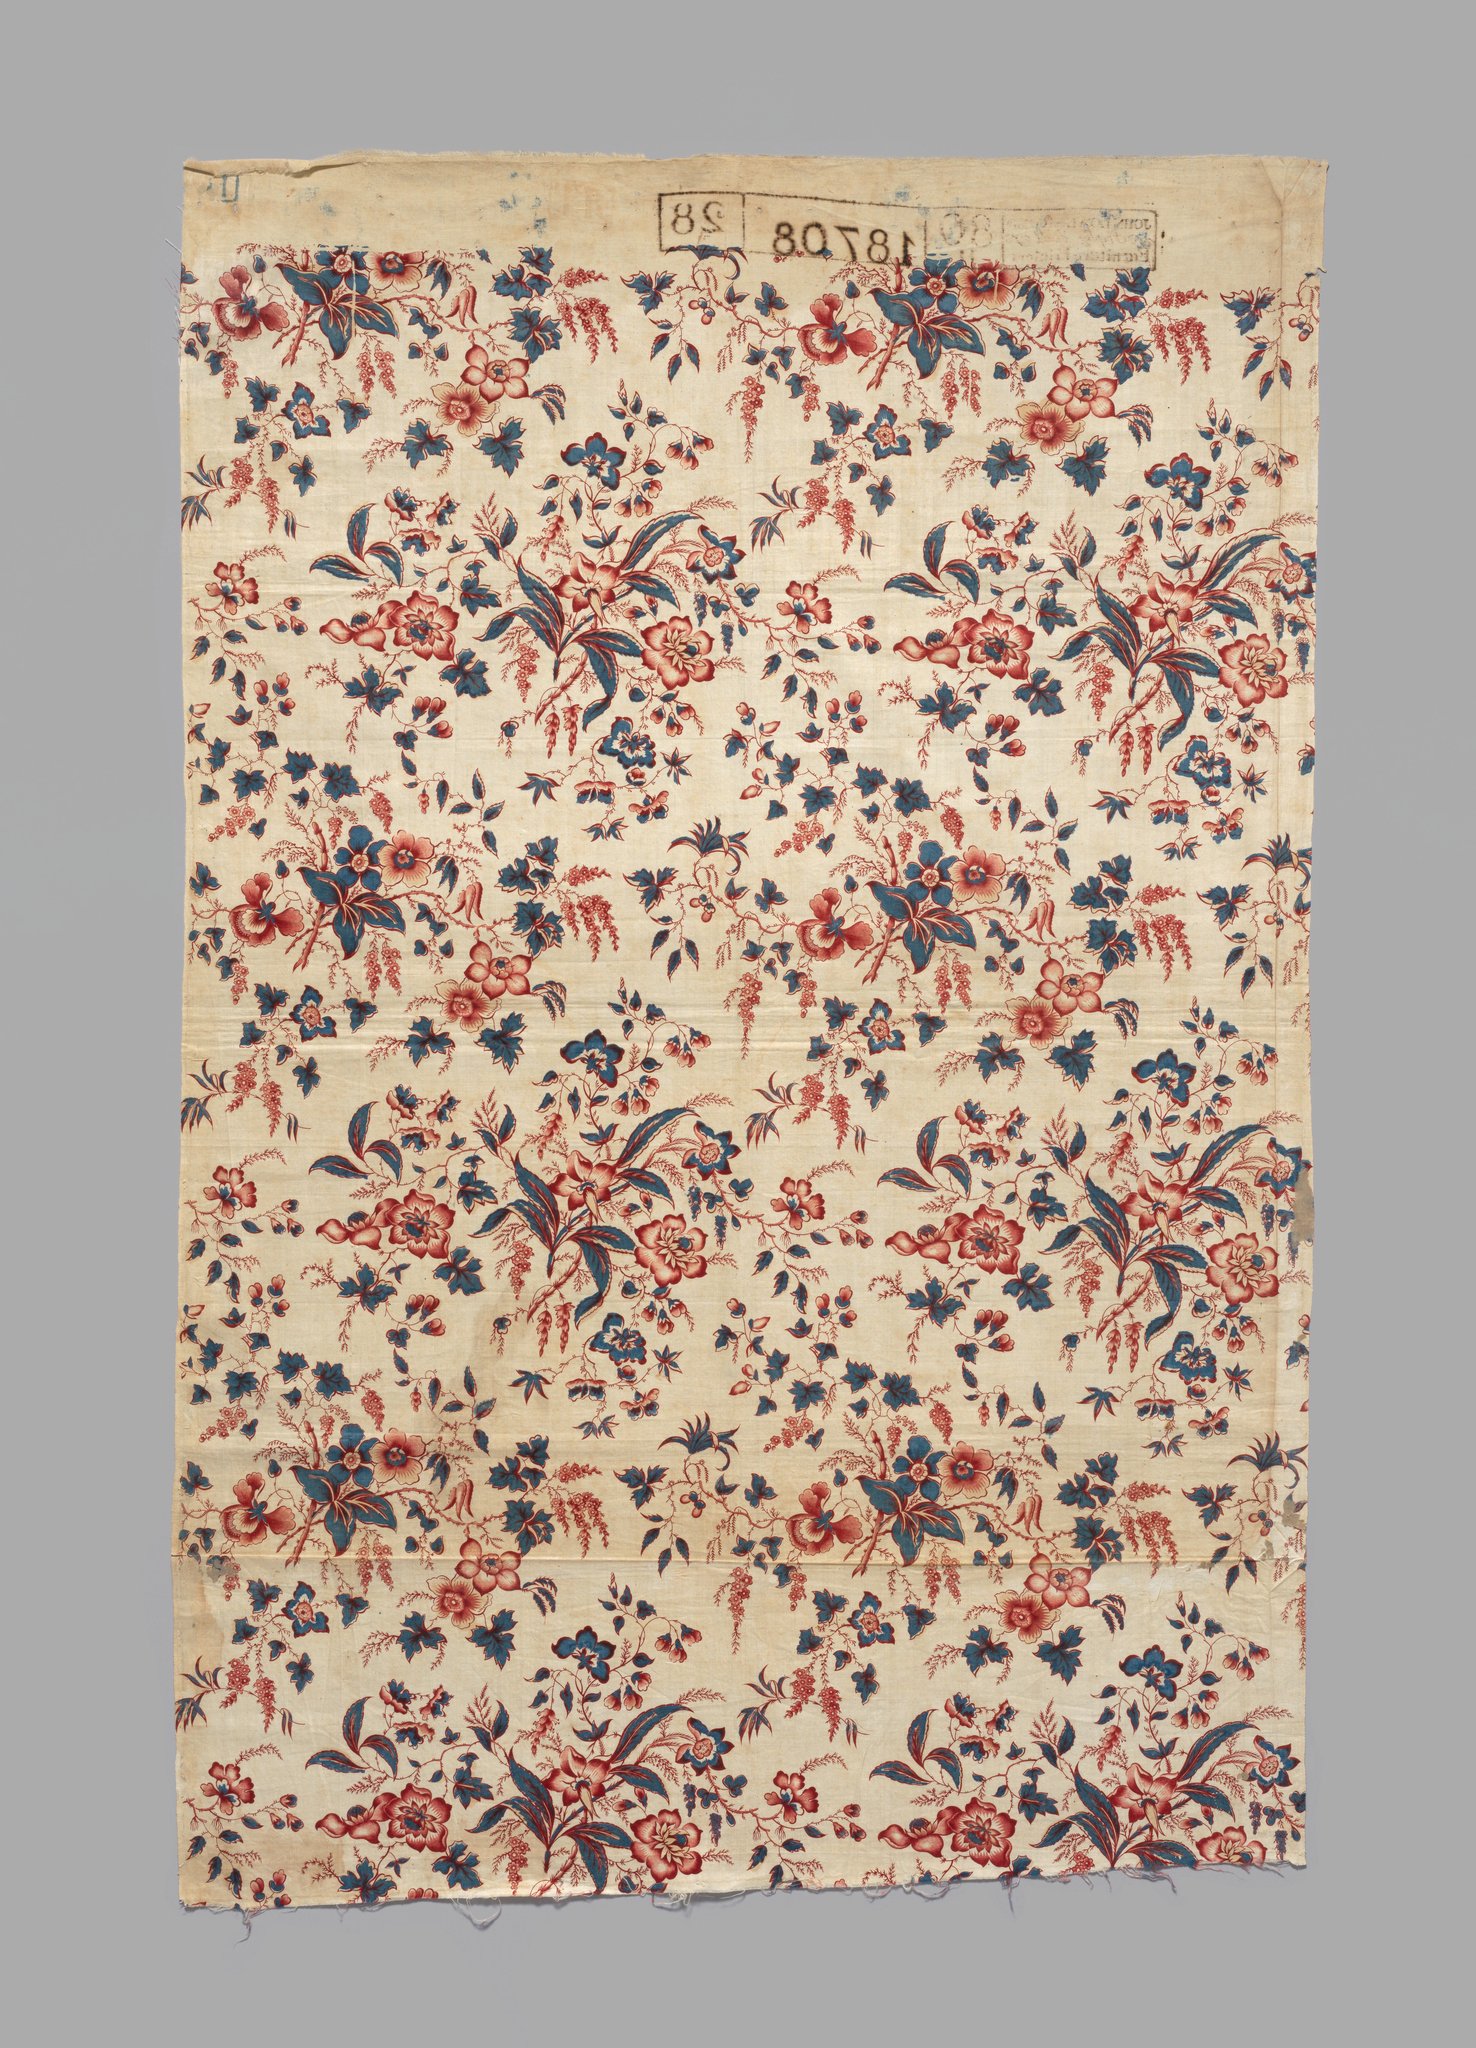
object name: piece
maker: john lowe & co.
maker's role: maker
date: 1830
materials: cotton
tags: flowers